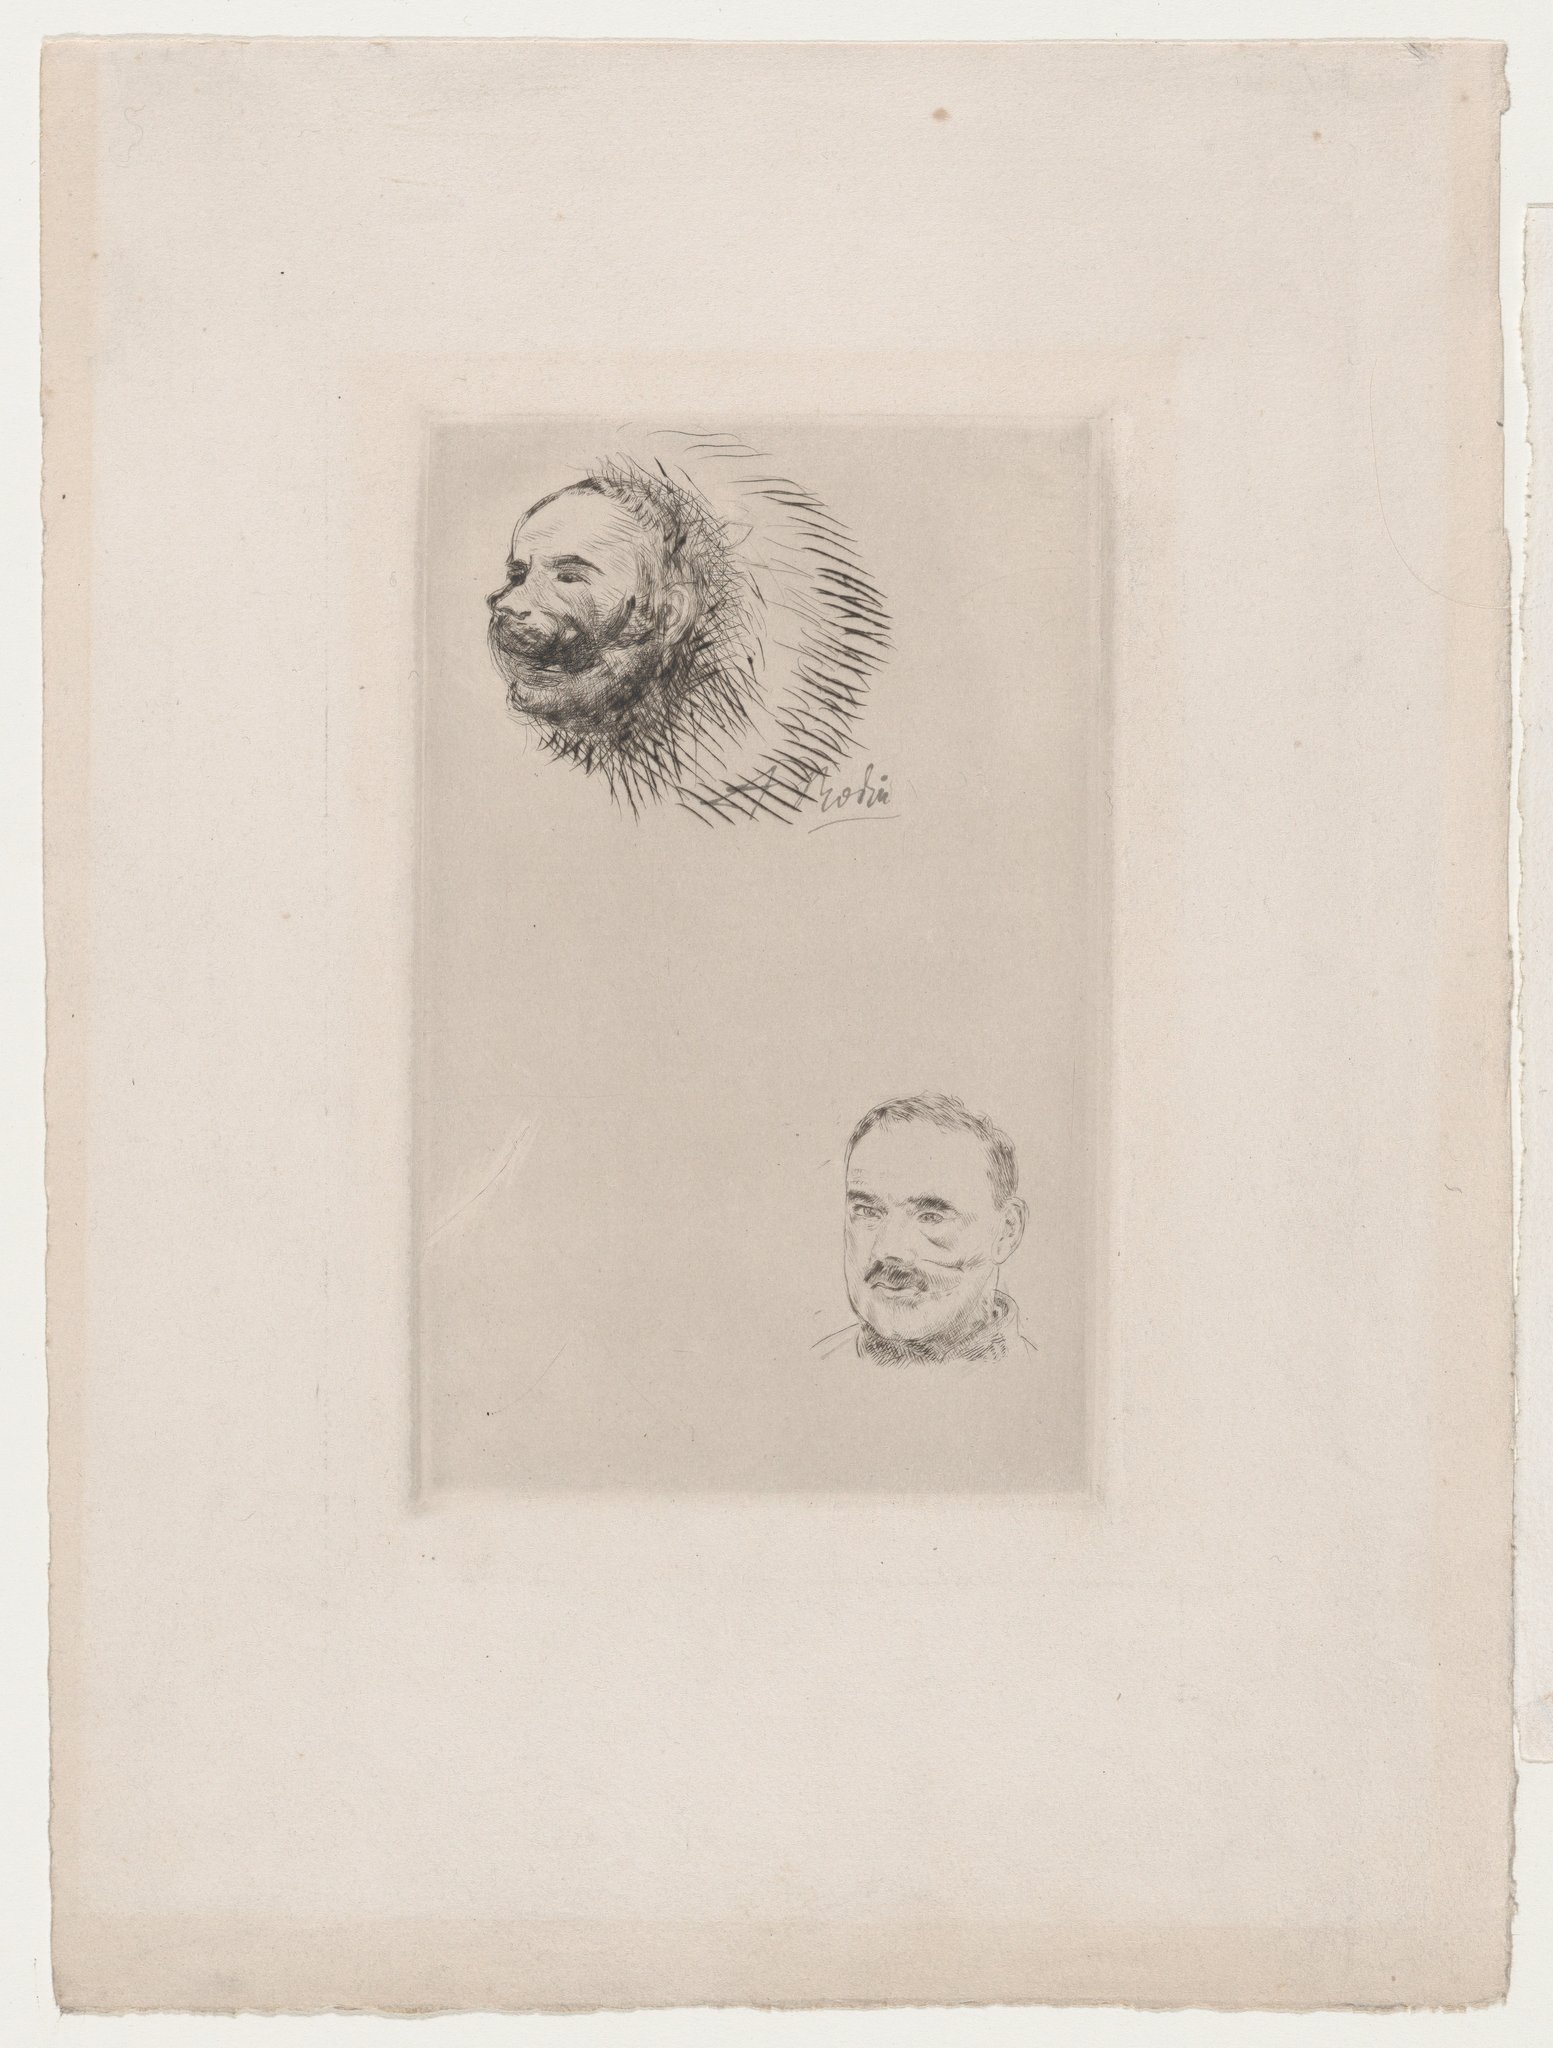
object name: print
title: Contribution Receipt of the Special American Hospital in Paris for Wounds of the Face and Jaw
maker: auguste rodin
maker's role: artist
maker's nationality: french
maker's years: 1840-1917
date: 1916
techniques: drypoint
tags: faces,men